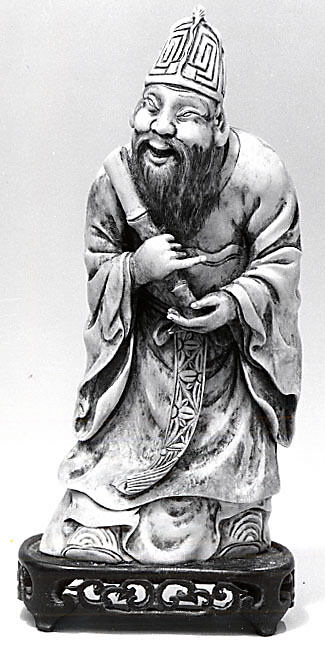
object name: statuette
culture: chinese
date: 1767-1800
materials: ivory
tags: men